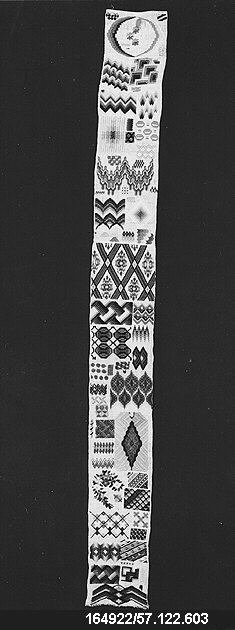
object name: sampler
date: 1801-1900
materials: canvas, wool